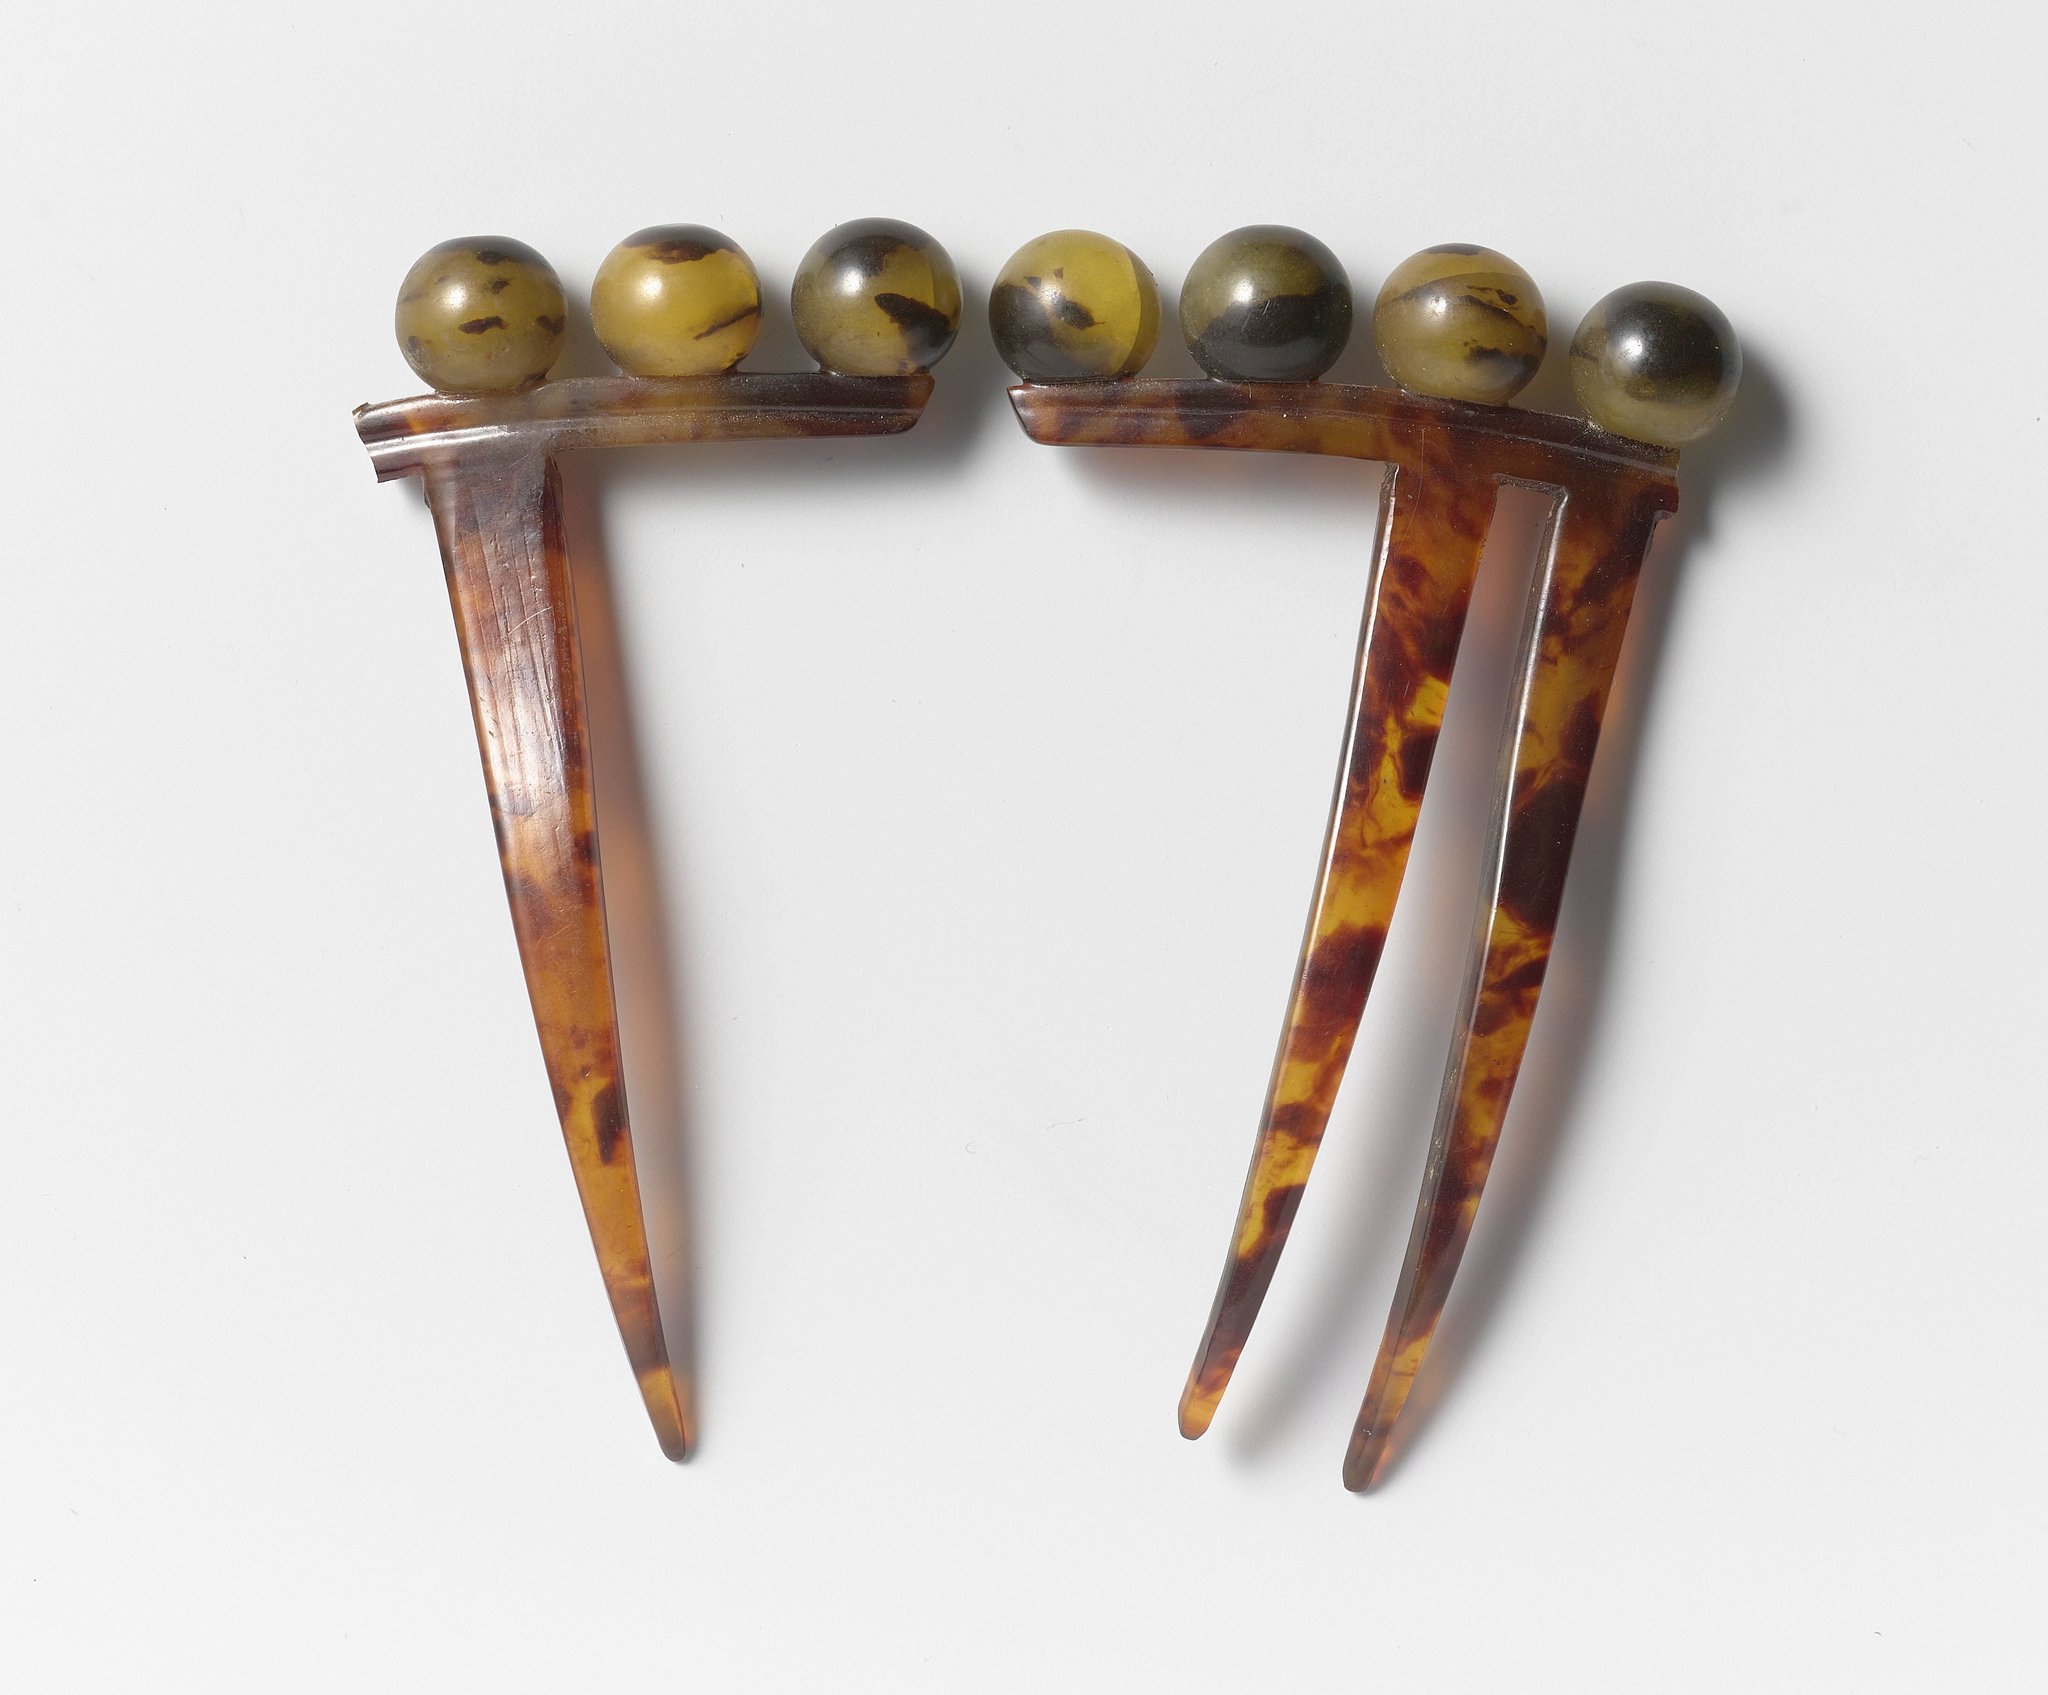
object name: comb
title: Haarkam van imitatie schildpad of hoorn met smalle rug waarop vijf bollen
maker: Anonymous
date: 1800-1810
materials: celluloid, plastic, horn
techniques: assembly, filing, polish, pressing, sawing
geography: netherlands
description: Haarkam van imitatie schildpad of hoorn met smalle rug waarop vijf bollen. Drie tanden.